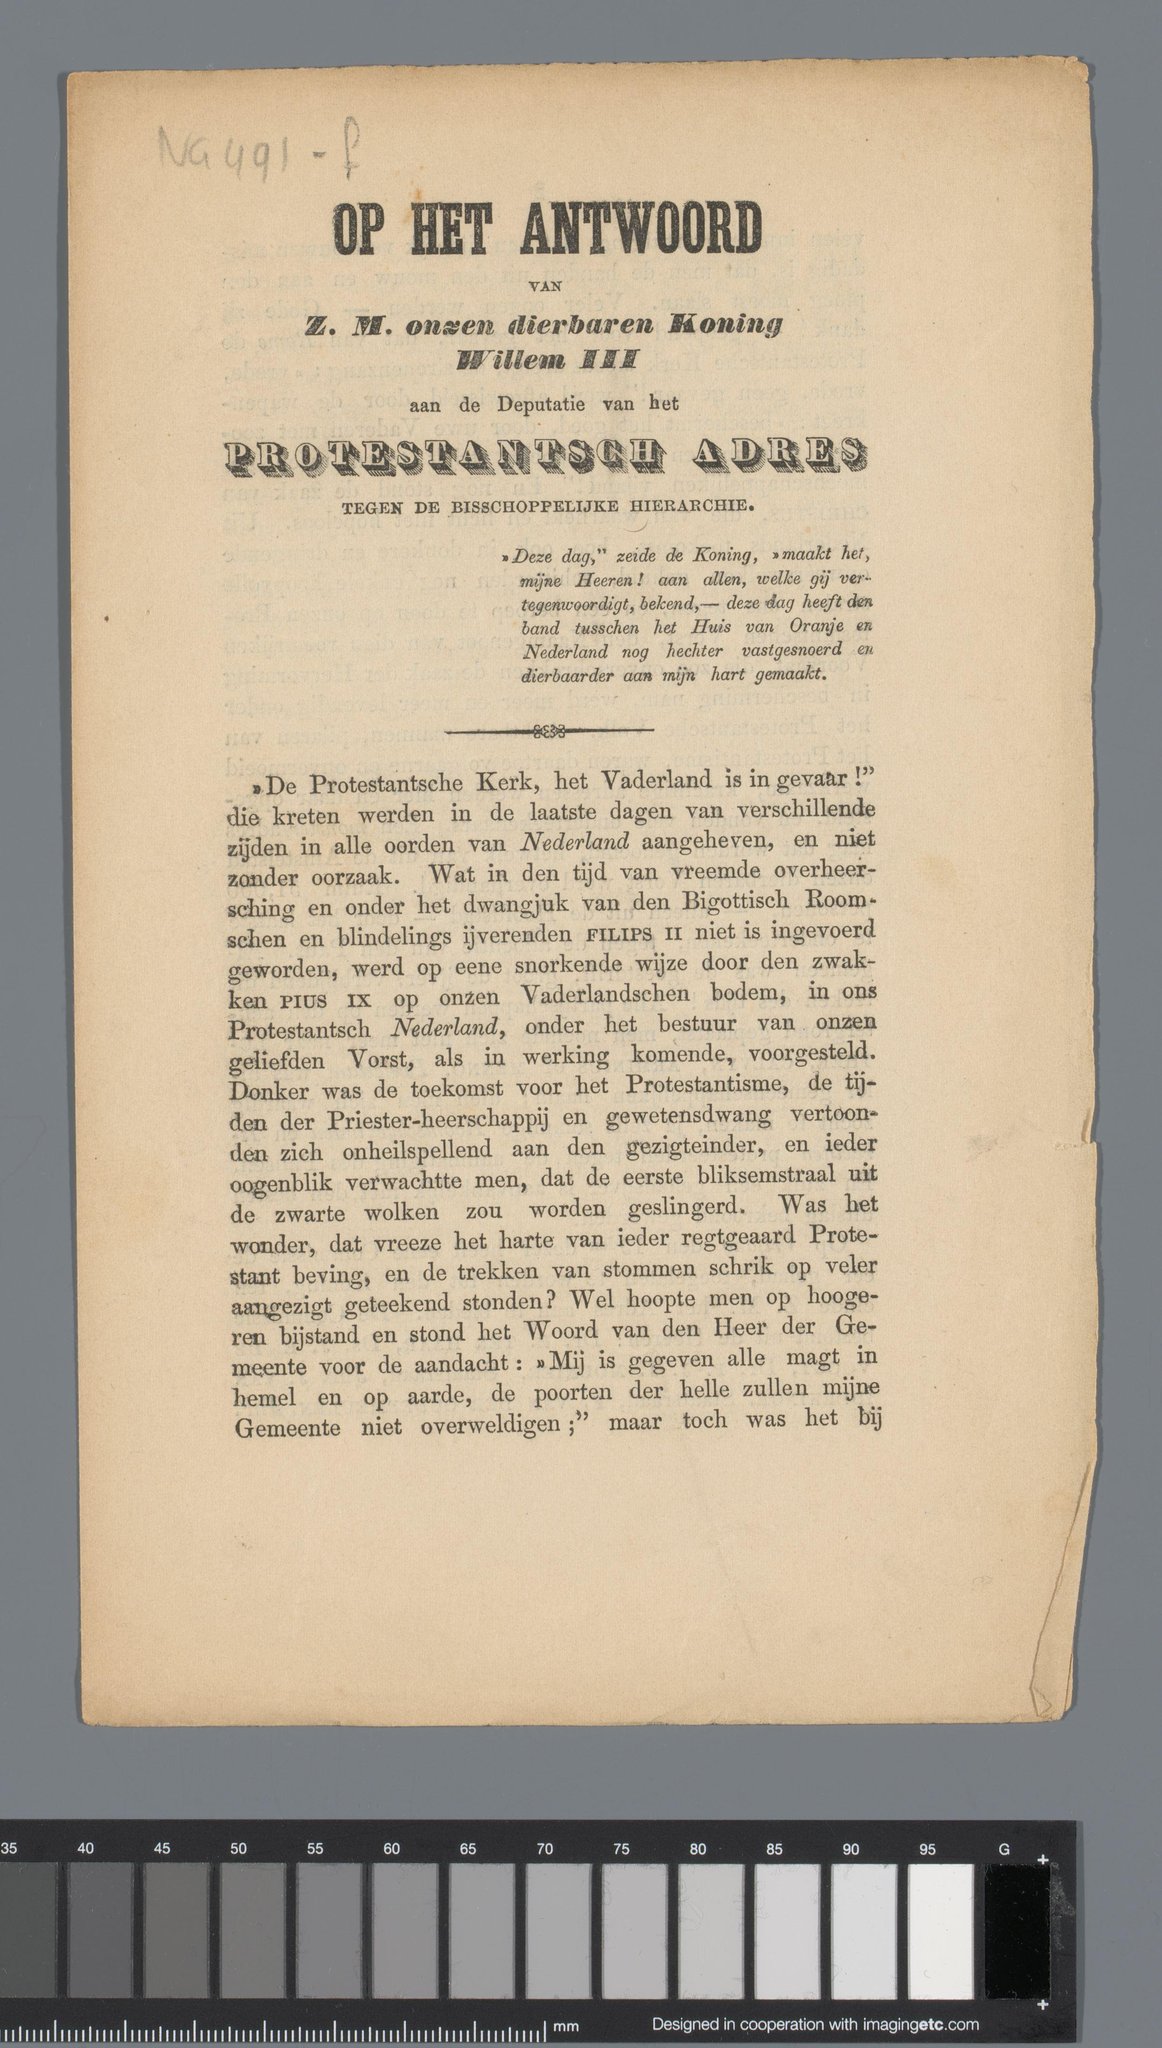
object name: pamphlet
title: Op het antwoord van Z.M. onzen dierbaren Koning Willem III aan de Deputatie van het Protestantsch Adres...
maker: dirk allart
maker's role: printer, publisher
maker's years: 1818-1887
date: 1853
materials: paper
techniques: printing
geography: amsterdam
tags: netherlands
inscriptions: date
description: Vouwblad van vier bedrukte pp, gericht tegen de instelling van de bisschoppelijke hiërarchie. Van protestantse oorsprong.